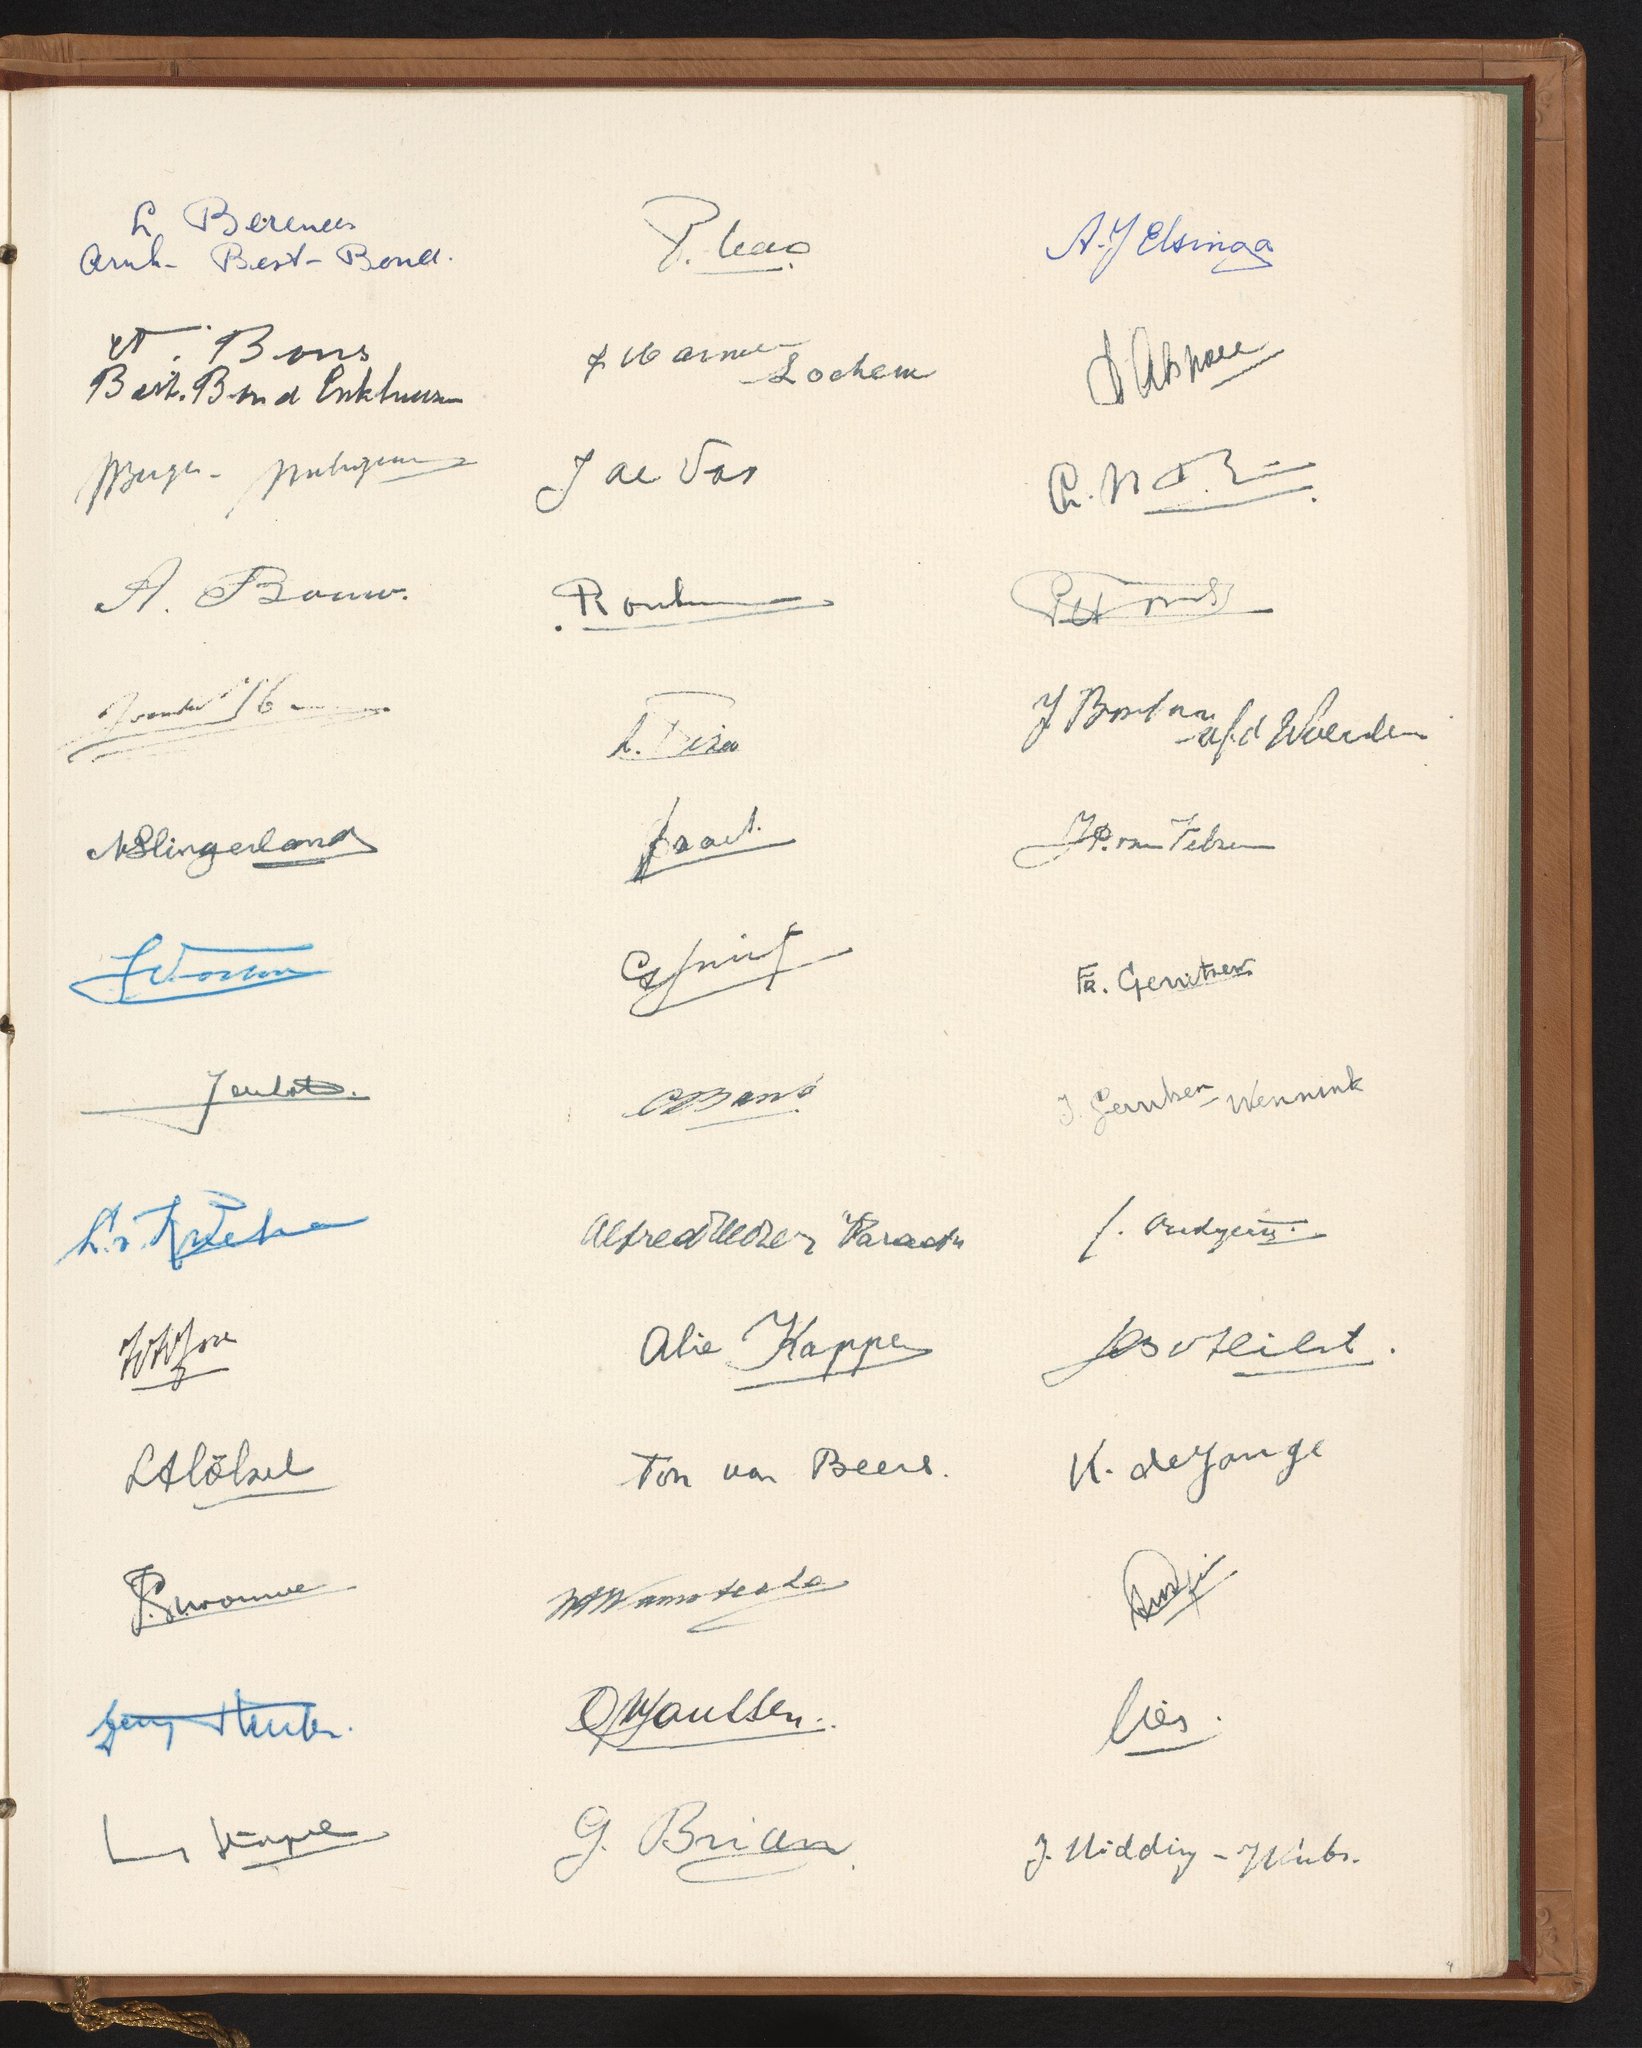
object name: album leaf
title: Blad met handtekeningen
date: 1949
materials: ink, paper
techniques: handwriting, pen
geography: netherlands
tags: modern professional organization, trade union, reception, cocktail party, handwriting, written text, amsterdam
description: Blad met handtekeningen van aanwezigen op het afscheidsfeest. Onderdeel van het fotoalbum ter gelegenheid van het afscheid van Evert Kupers als voorzitter van de NVV op 14 juli 1949 in Amsterdam.